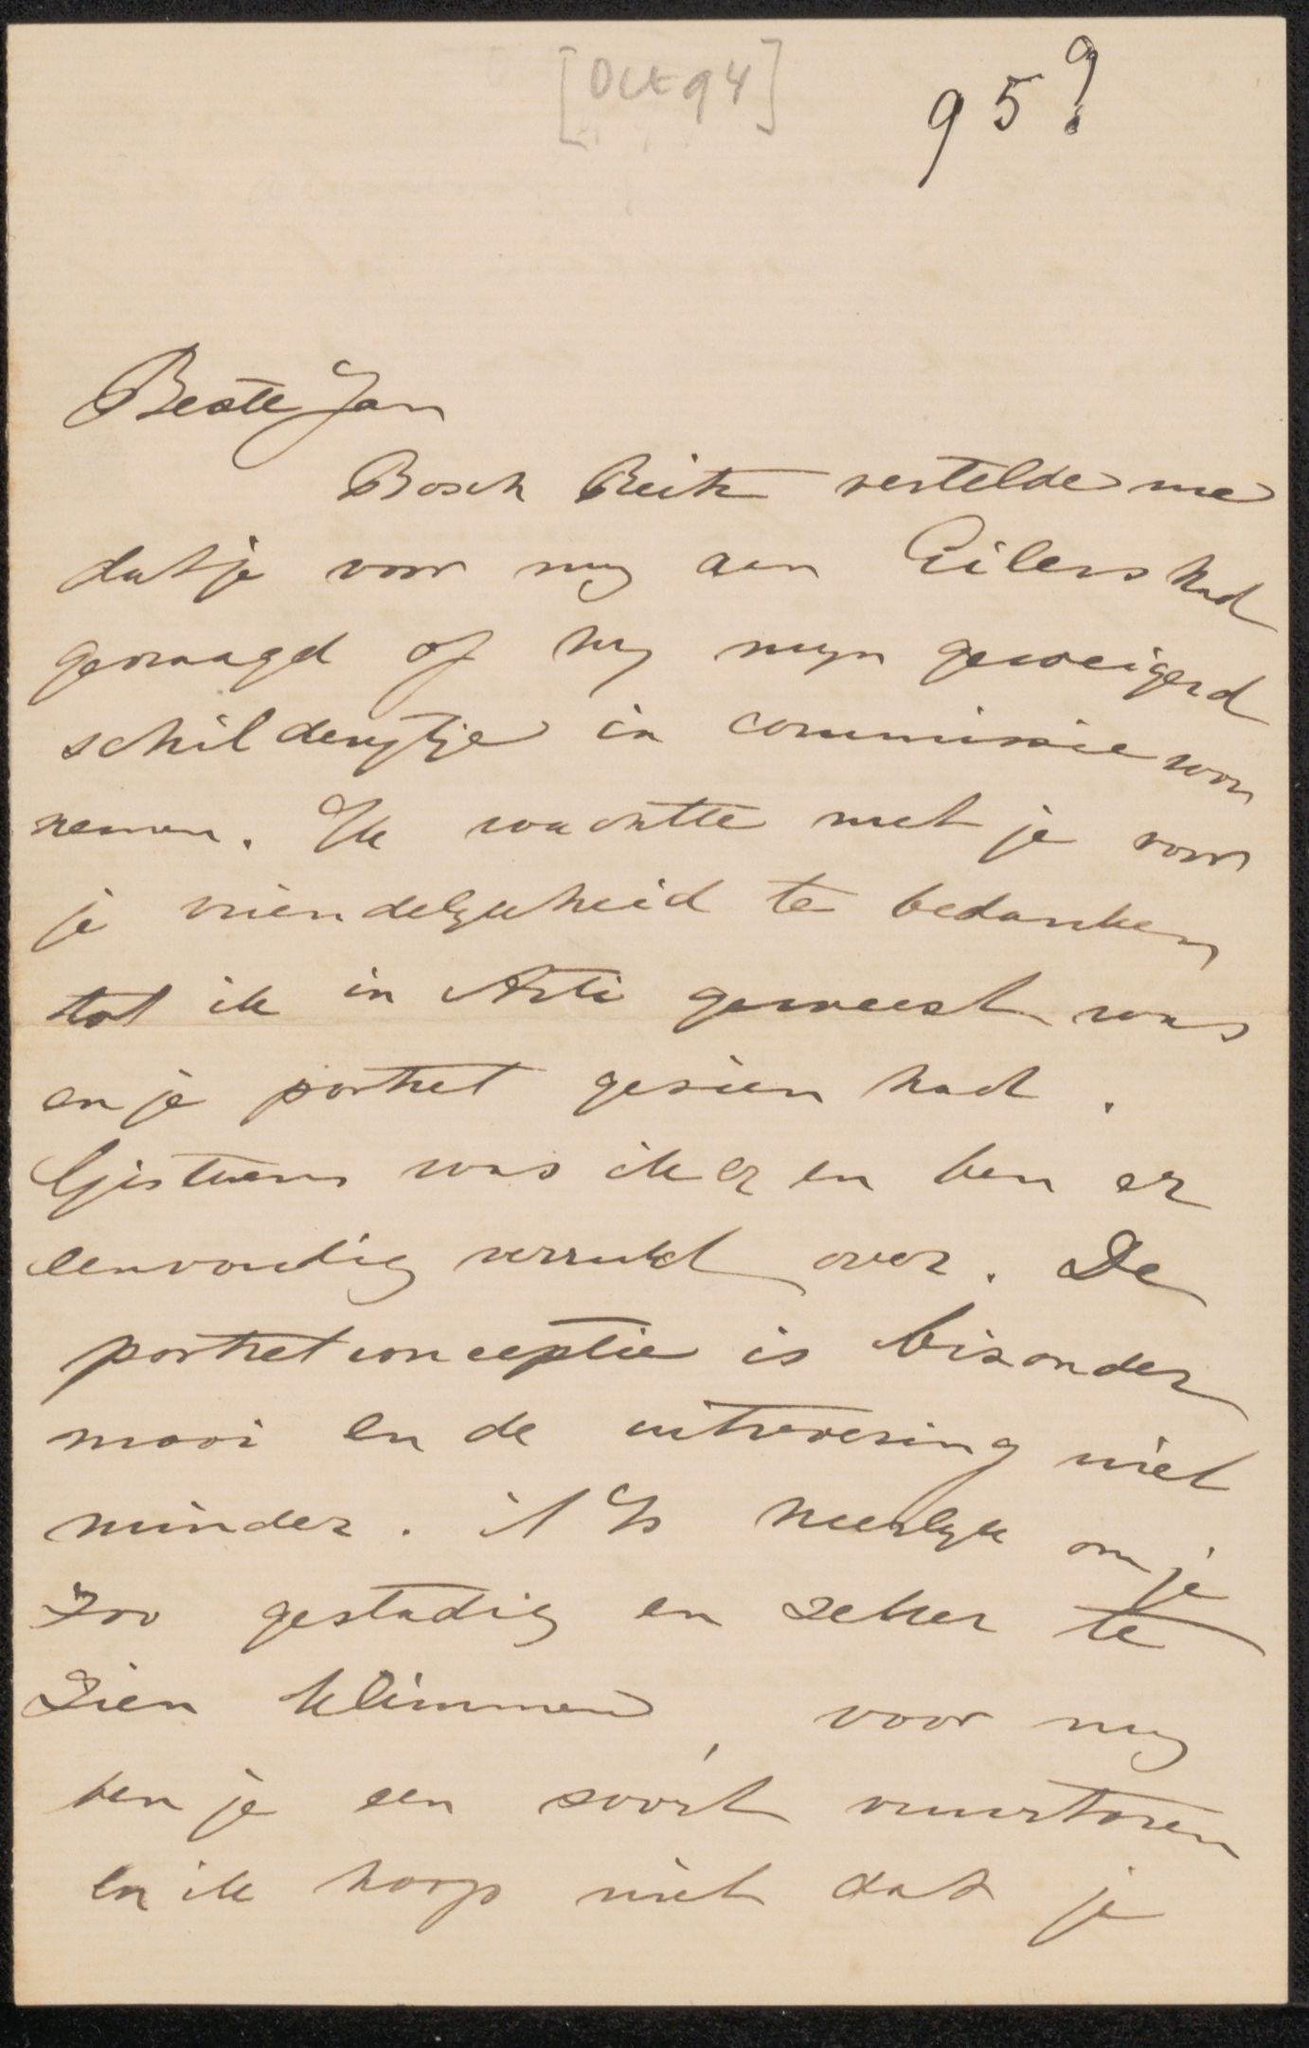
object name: letter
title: Brief aan Jan Veth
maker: wally moes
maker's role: draughtsman, print maker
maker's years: 1856-1918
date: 1874-1918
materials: ink, paper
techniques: pen, writing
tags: dordrecht, print maker, draughtsman, designer, jan veth, jacob simon hendrik kever, bernard eilers, the hague, willem kloos, arnhem, sculptor, saar de swart, amsterdam, painter, gijs bosch reitz, painting (including book-illumination, miniature-painting), exhibition ~ art, historical persons (portraits and scenes from the life)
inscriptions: collector's mark: ‘RPK’